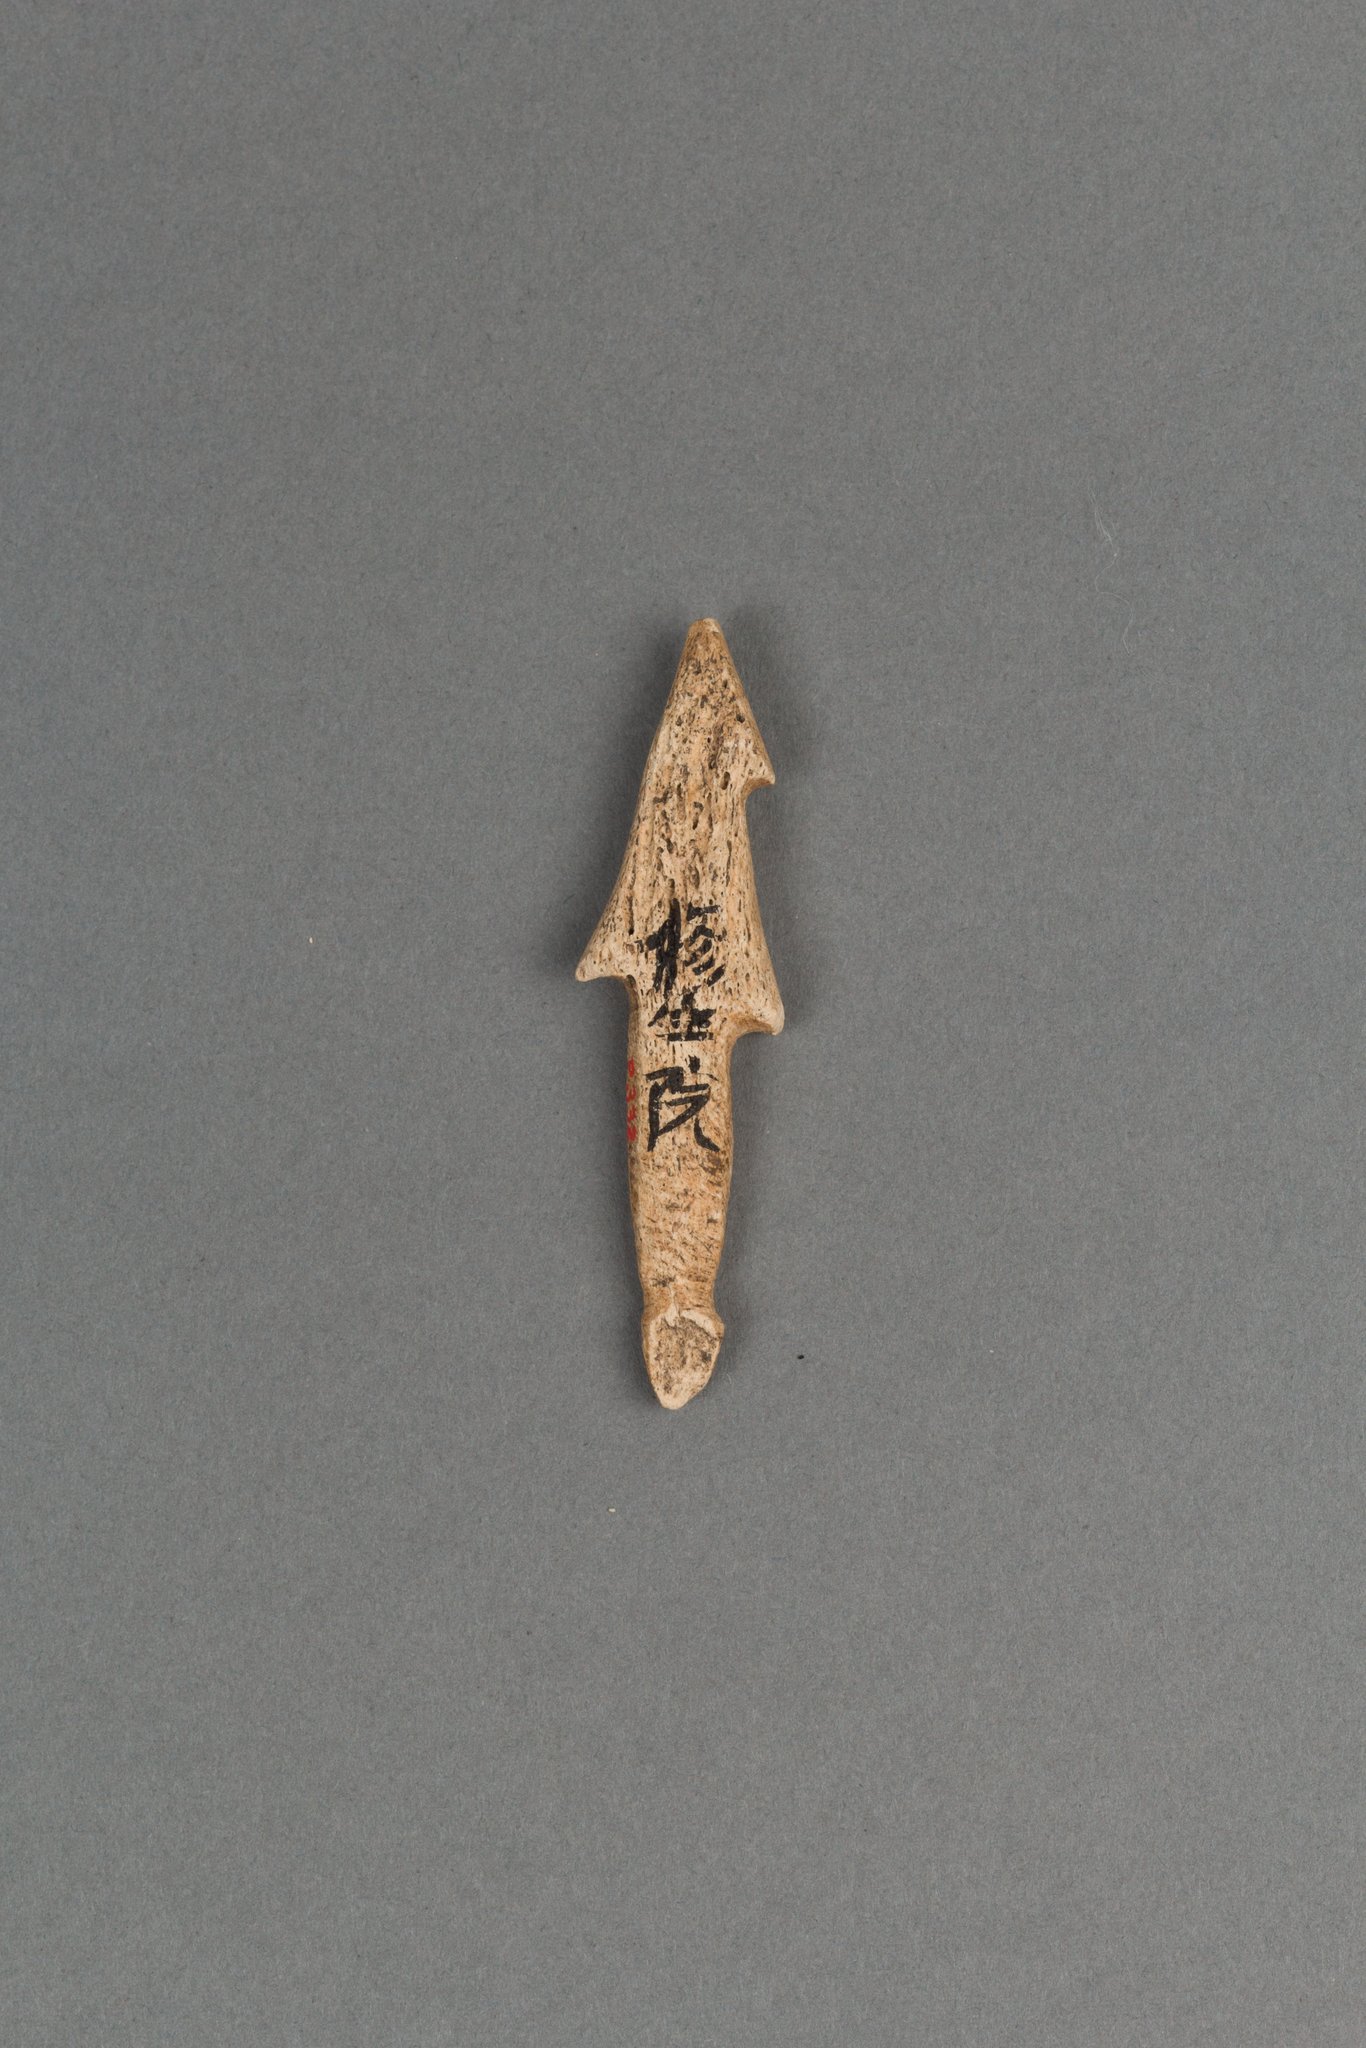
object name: harpoon head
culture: japanese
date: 1200-200 BCE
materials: bone